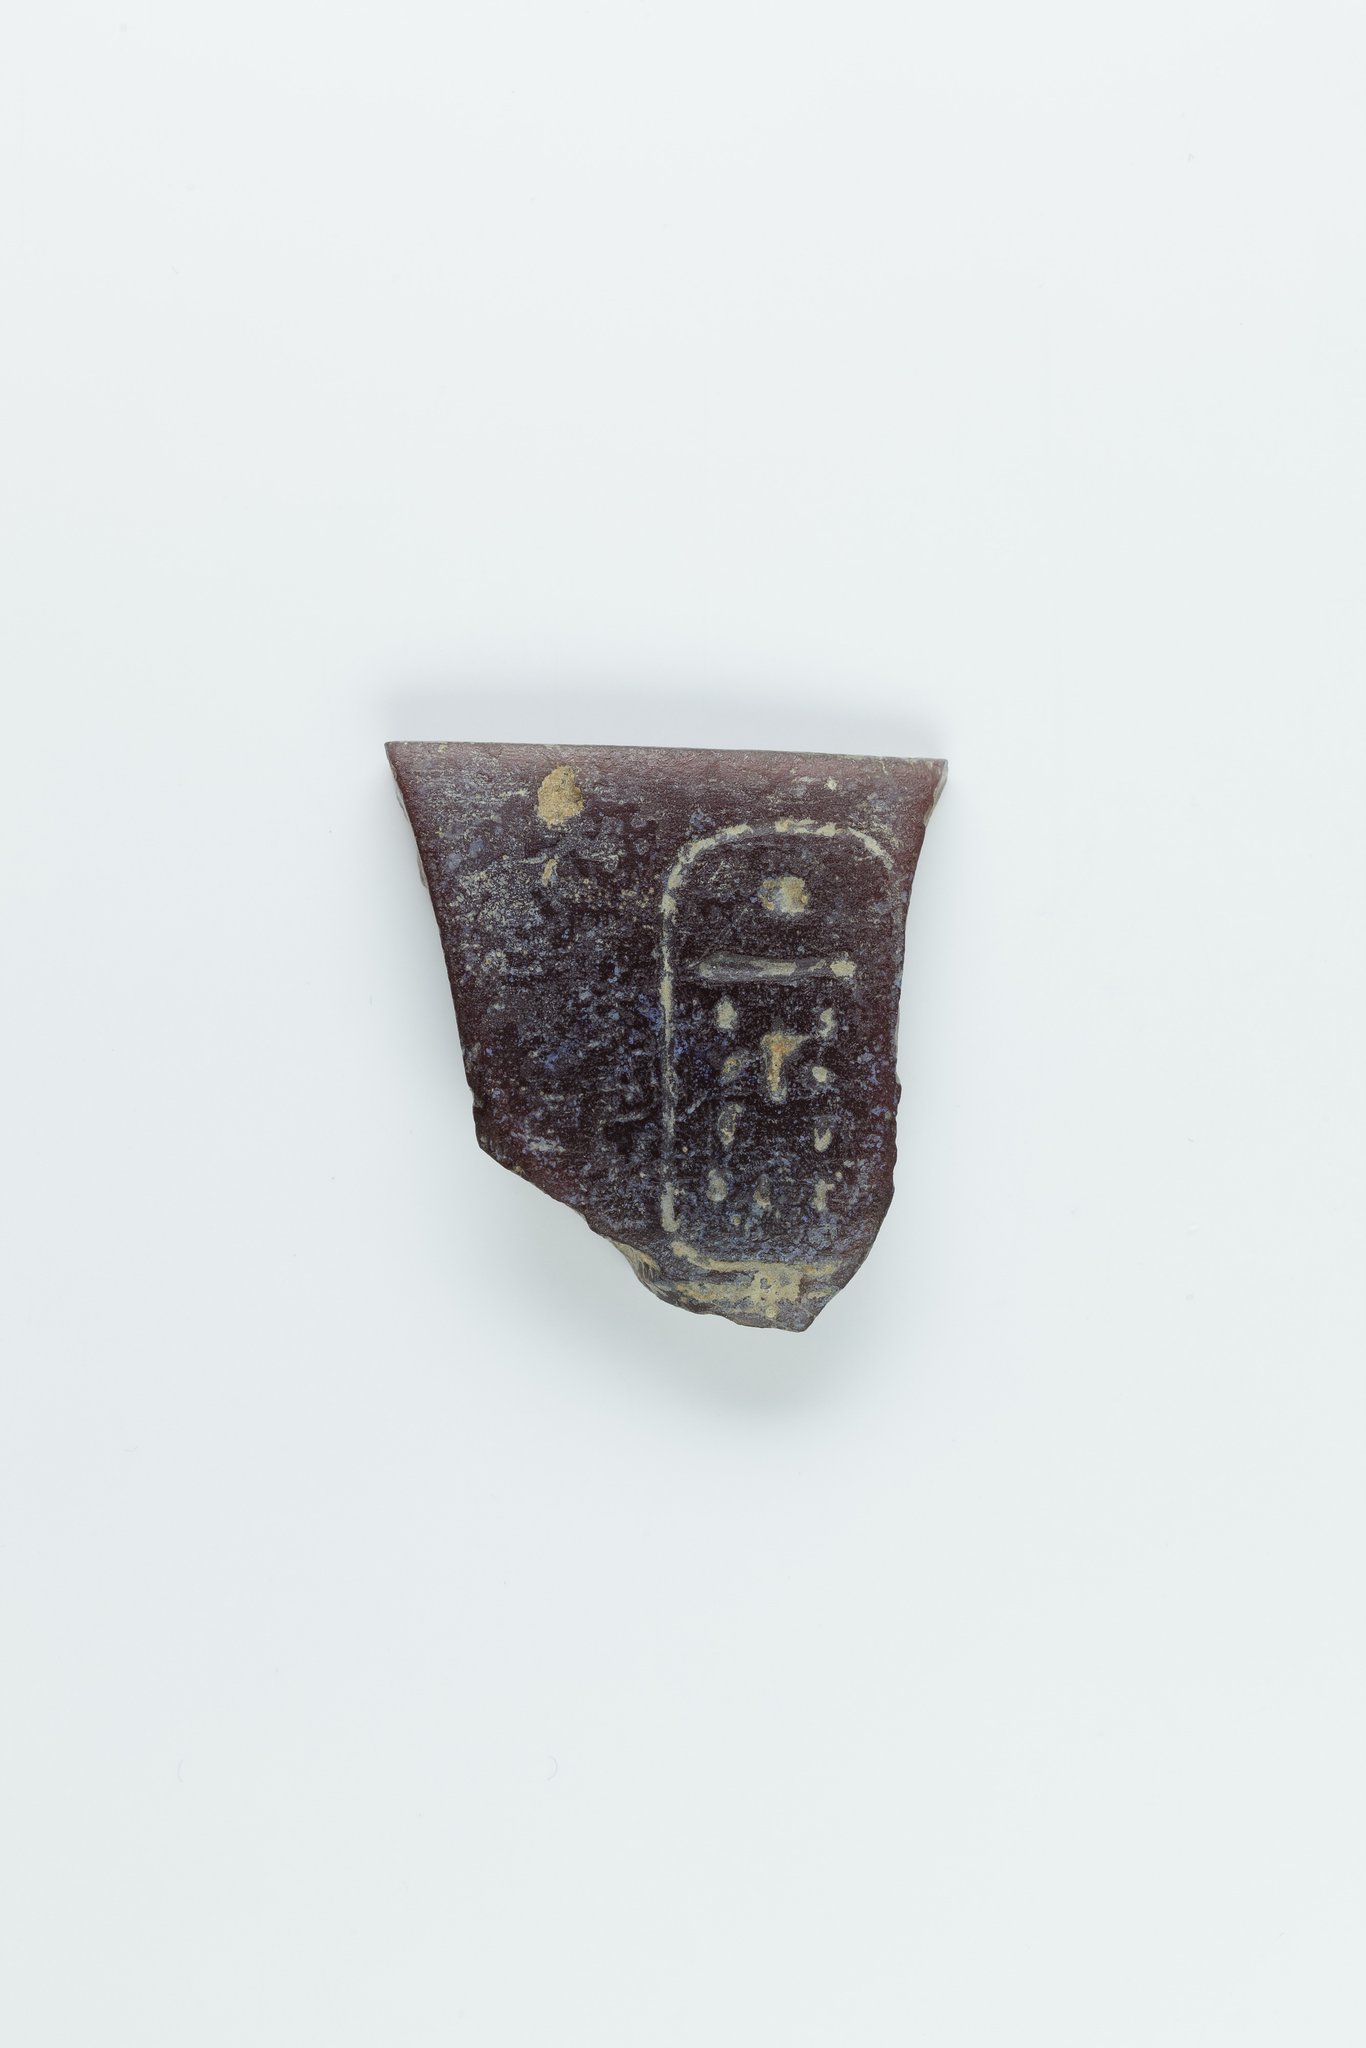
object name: vessel fragment, rim, amenhotep ii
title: Rim Shard Incised with the Name of Amenhotep II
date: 1427-1400 BCE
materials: glass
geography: egypt